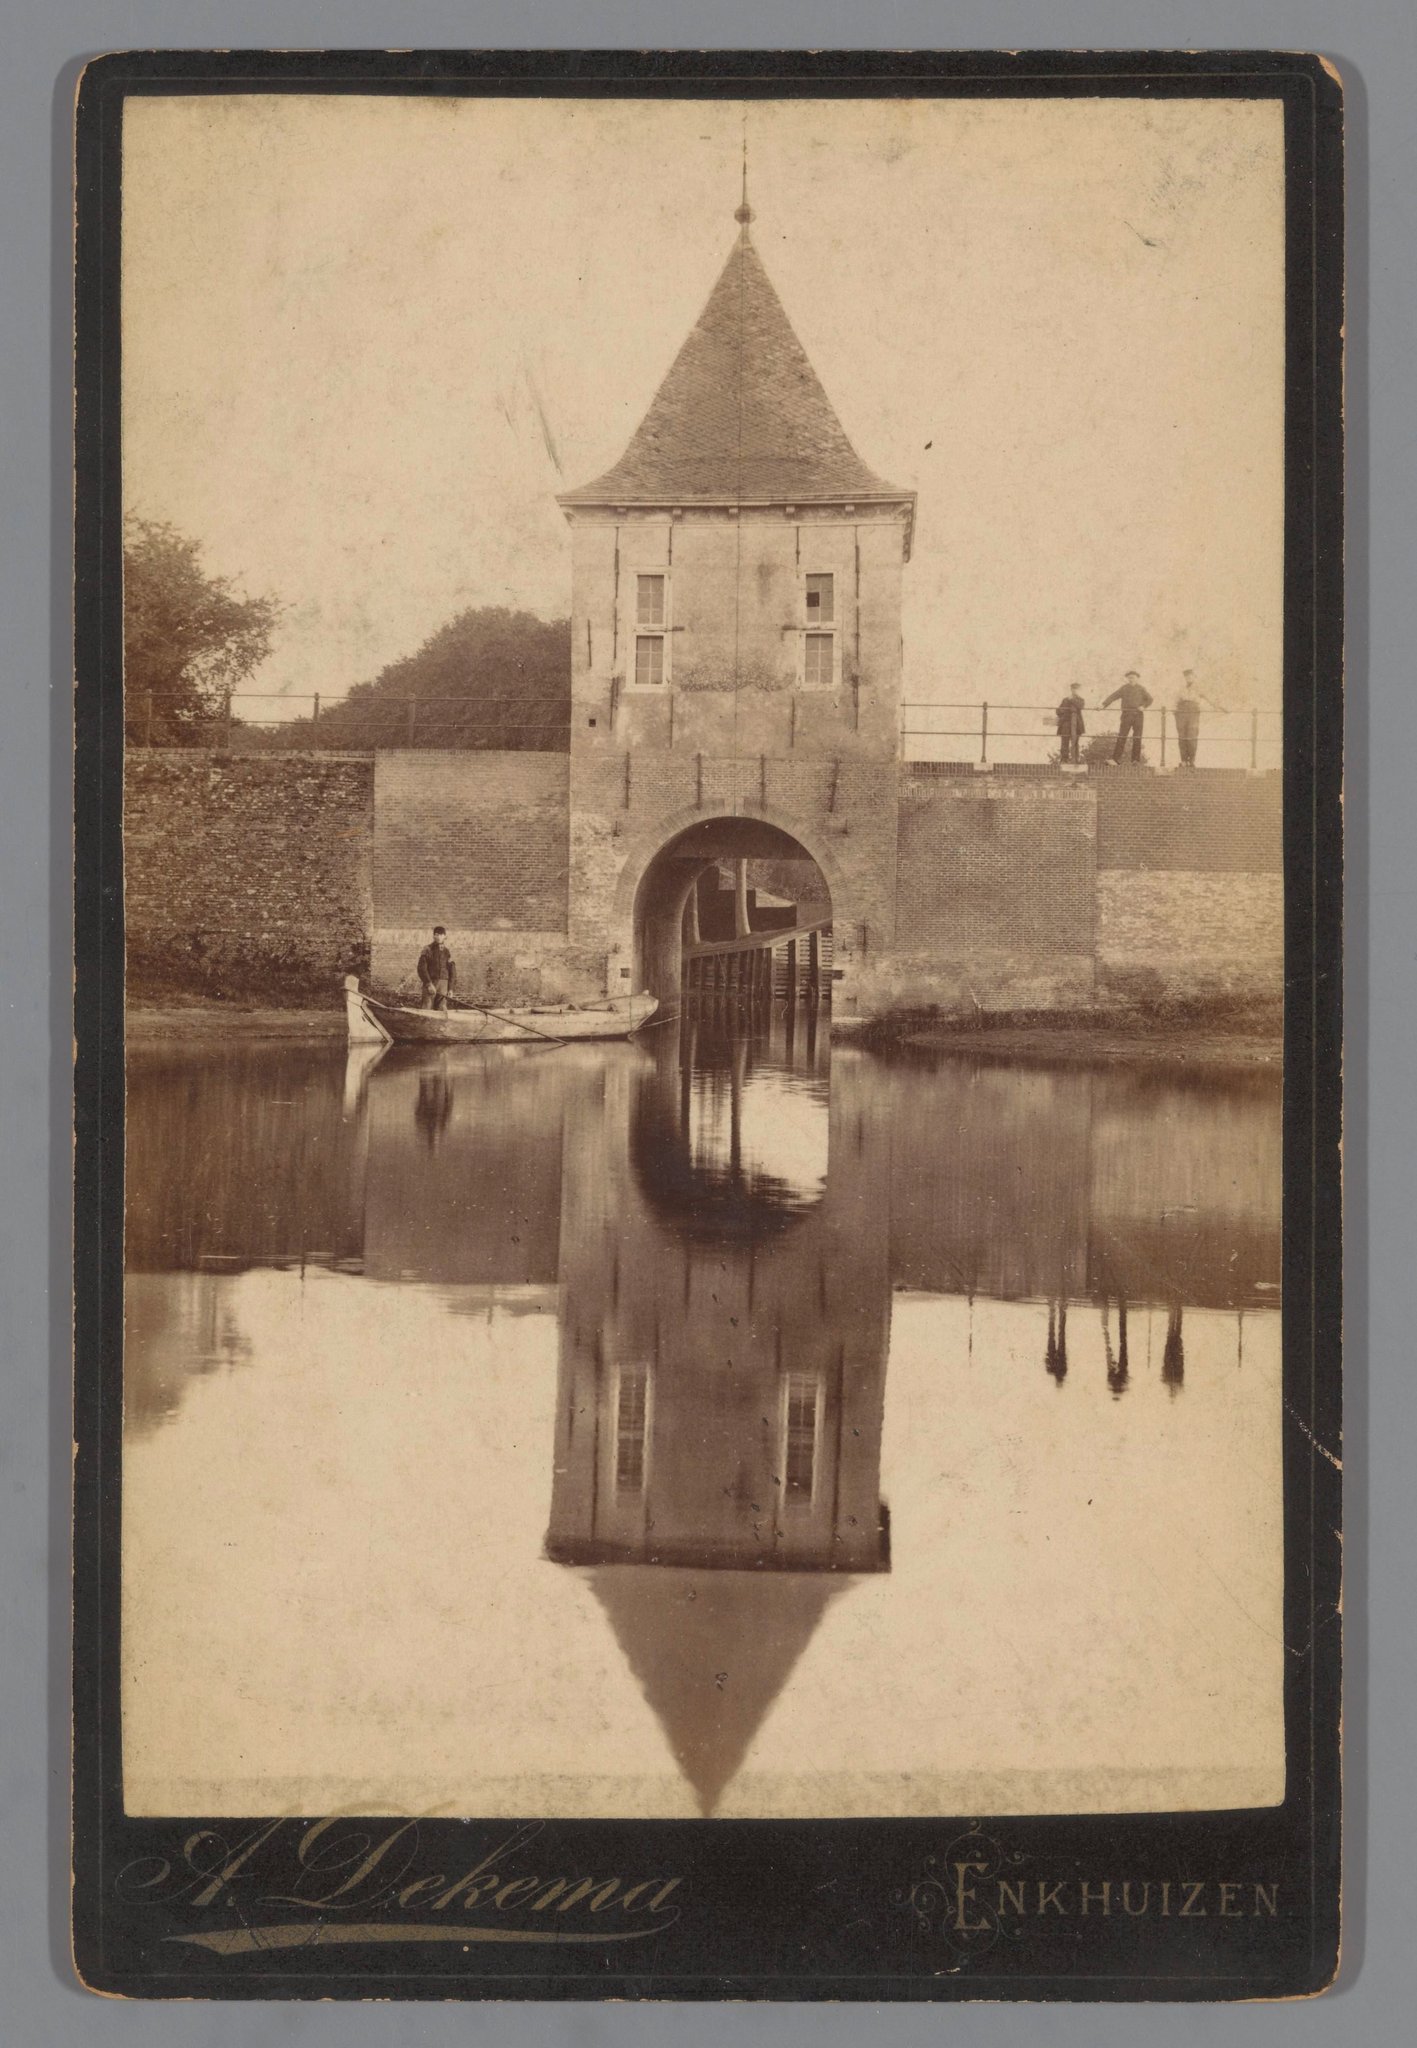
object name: photograph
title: Gezicht op de waterpoort de Oude Gouwsboom in Enkhuizen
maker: albert dekema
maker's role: publisher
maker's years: 1824-1909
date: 1865-1896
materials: cardboard, photographic support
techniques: albumen print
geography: enkhuizen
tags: watergate, enkhuizen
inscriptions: annotation: ‘Enkhuizen/ Veiling’